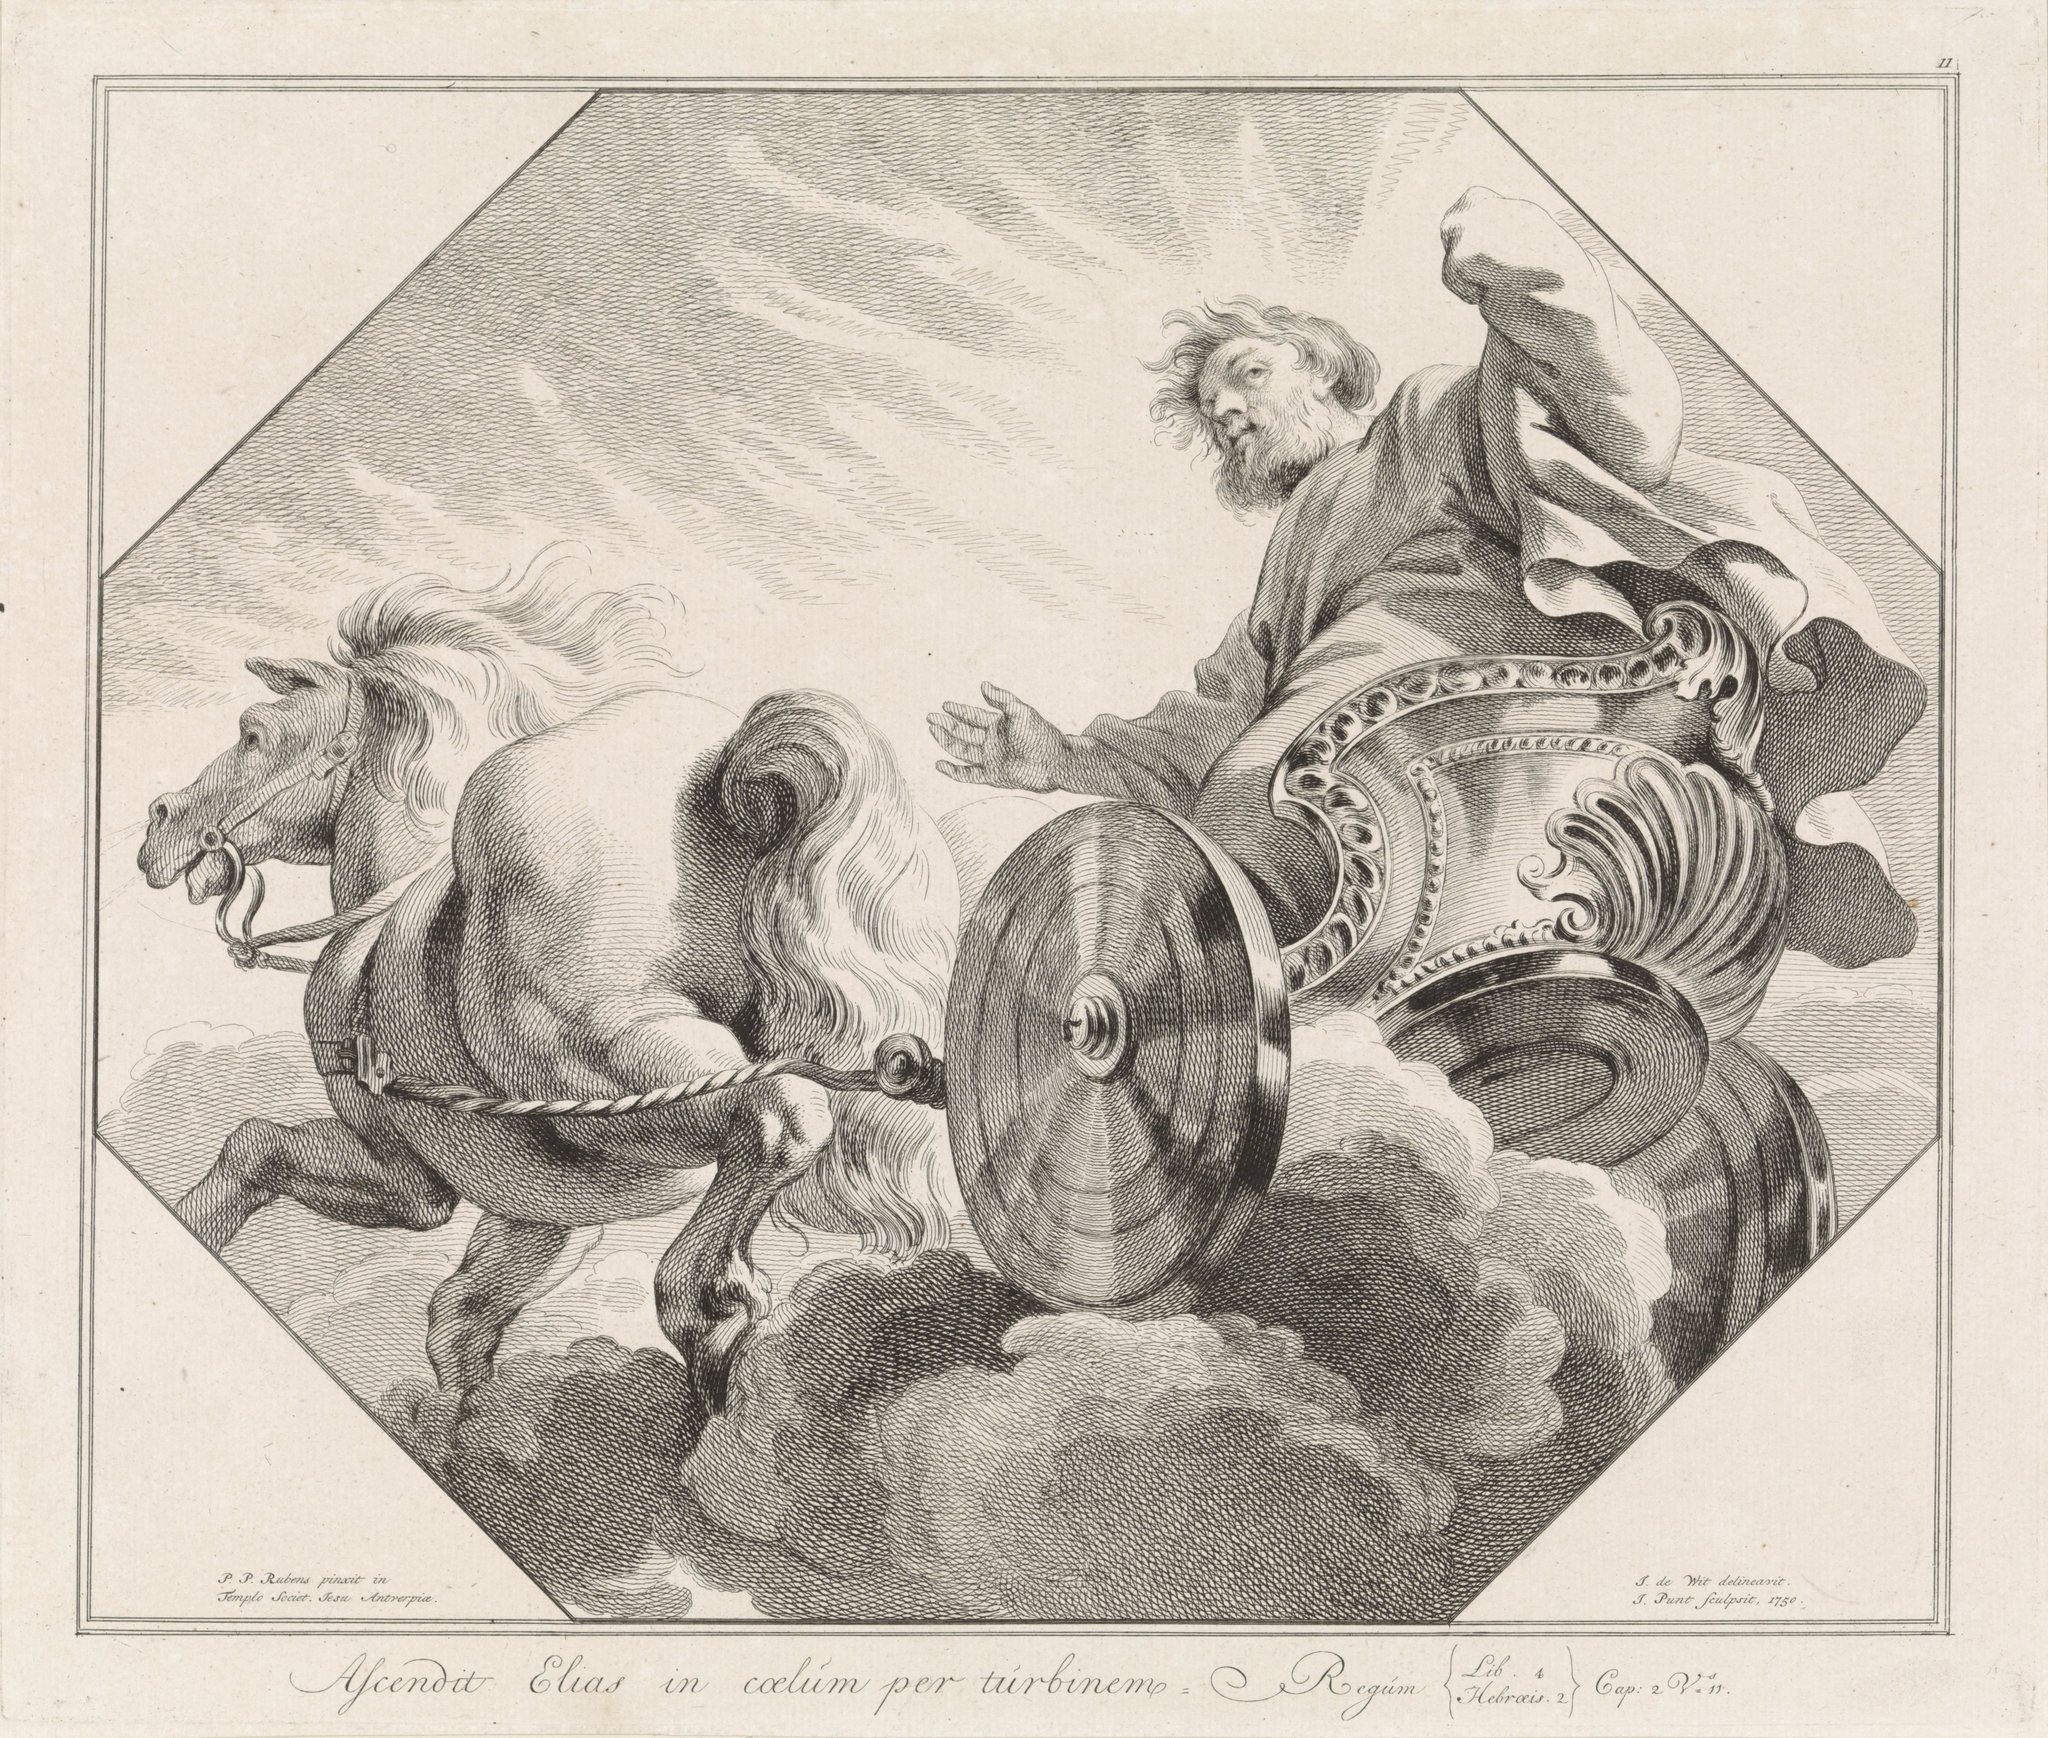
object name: print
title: Hemelvaart van Elia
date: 1750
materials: paper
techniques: engraving, etching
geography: amsterdam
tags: a chariot, horses of fire and a whirlwind appear and elijah is carried up into heaven; elijah's cloak falls (or he hands it over to elisha)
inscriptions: collector's mark: Lugt 240, date: ‘1750’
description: Elia in een wagen getrokken door een paard in de wolken. Onder de octagonale voorstelling een vers in het Latijn uit 2 Kon. 2:11.